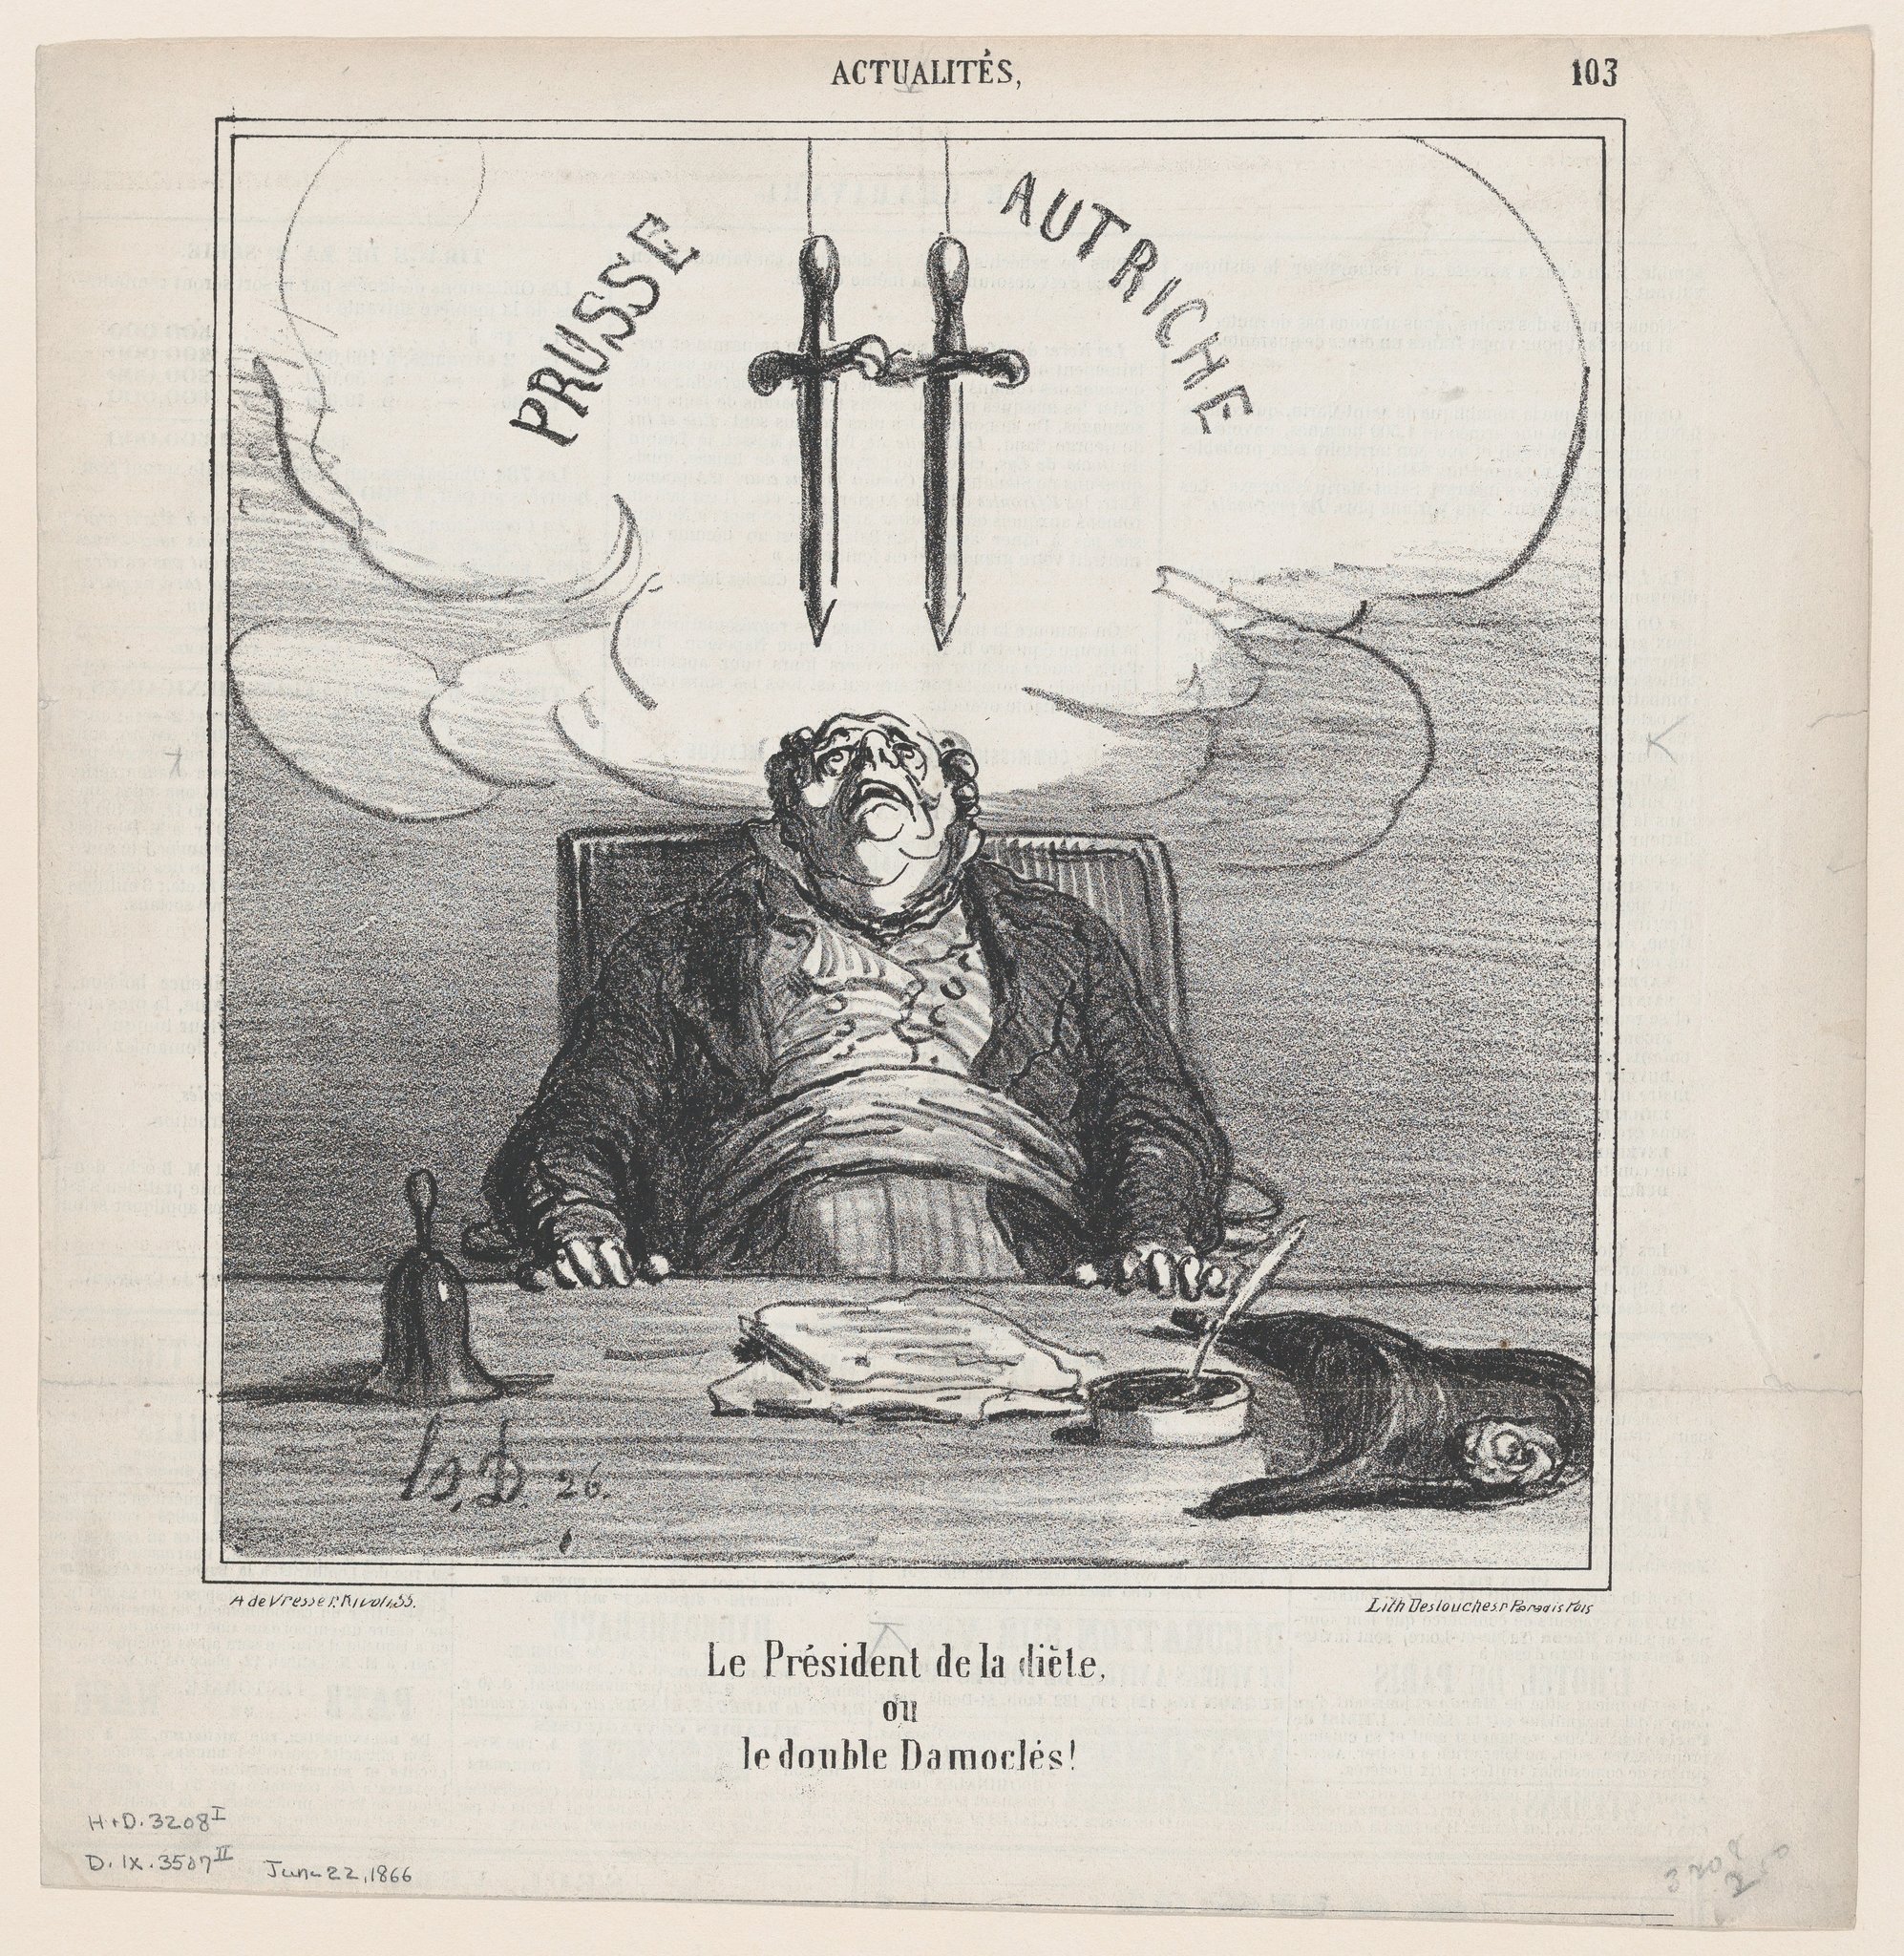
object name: print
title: The president of the federal diet or the double sword of Damocles, from "News of the Day"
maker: honoré daumier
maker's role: artist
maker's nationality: french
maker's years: 1808-1879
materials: paper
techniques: lithograph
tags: satire,swords,men,cross